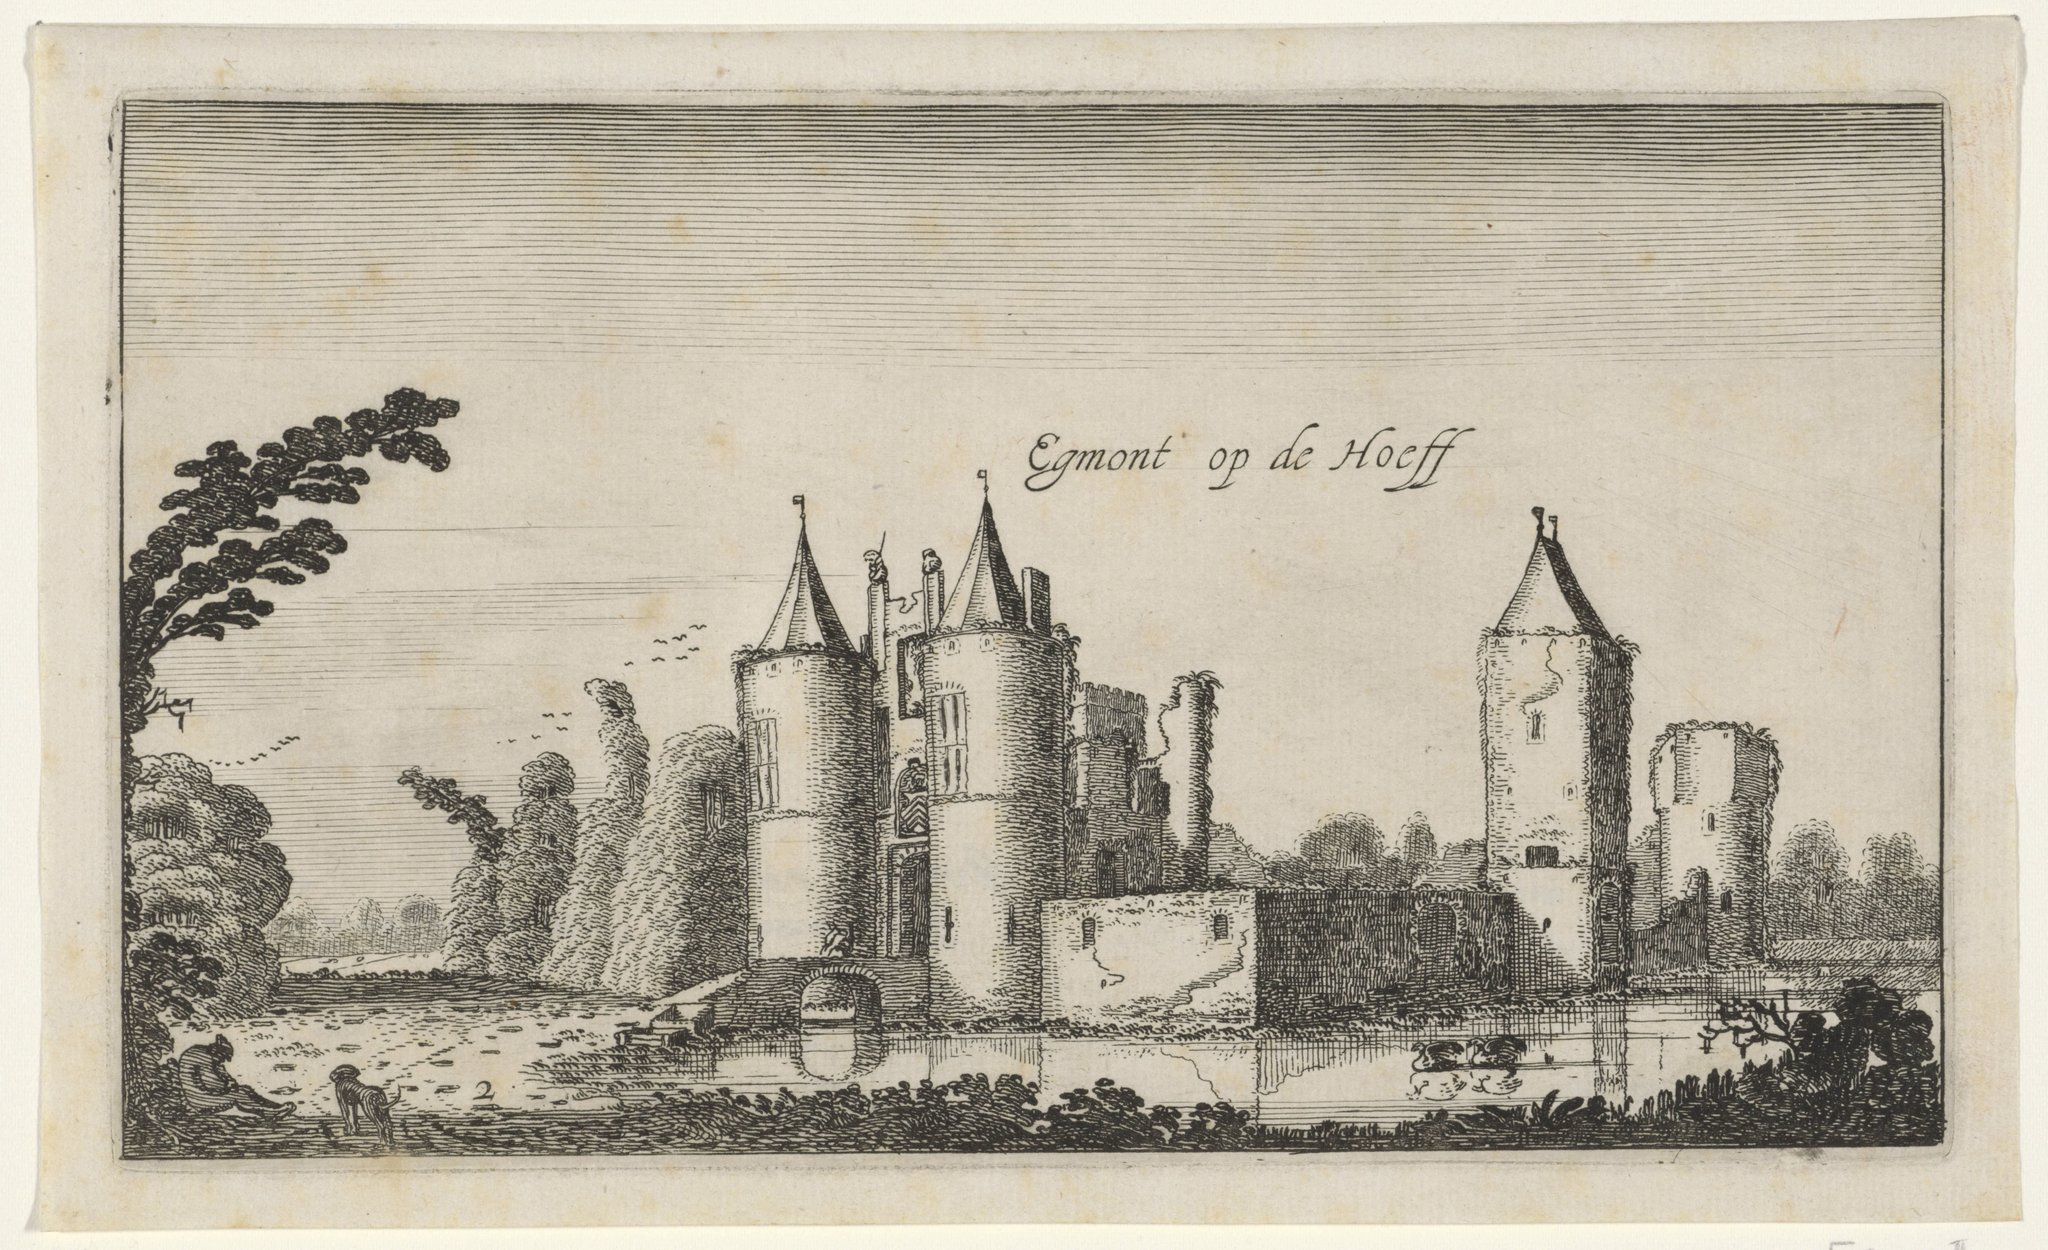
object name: print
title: Kastelen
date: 1616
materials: paper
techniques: etching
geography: northern netherlands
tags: landscape with ruins, landscape with tower or castle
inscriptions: collector's mark: Lugt 964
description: Ruïne van het kasteel van Egmond, waarvan de poort nog overeind staat, op de voorgrond links een man met een hond. Tweede prent uit een serie van zes.